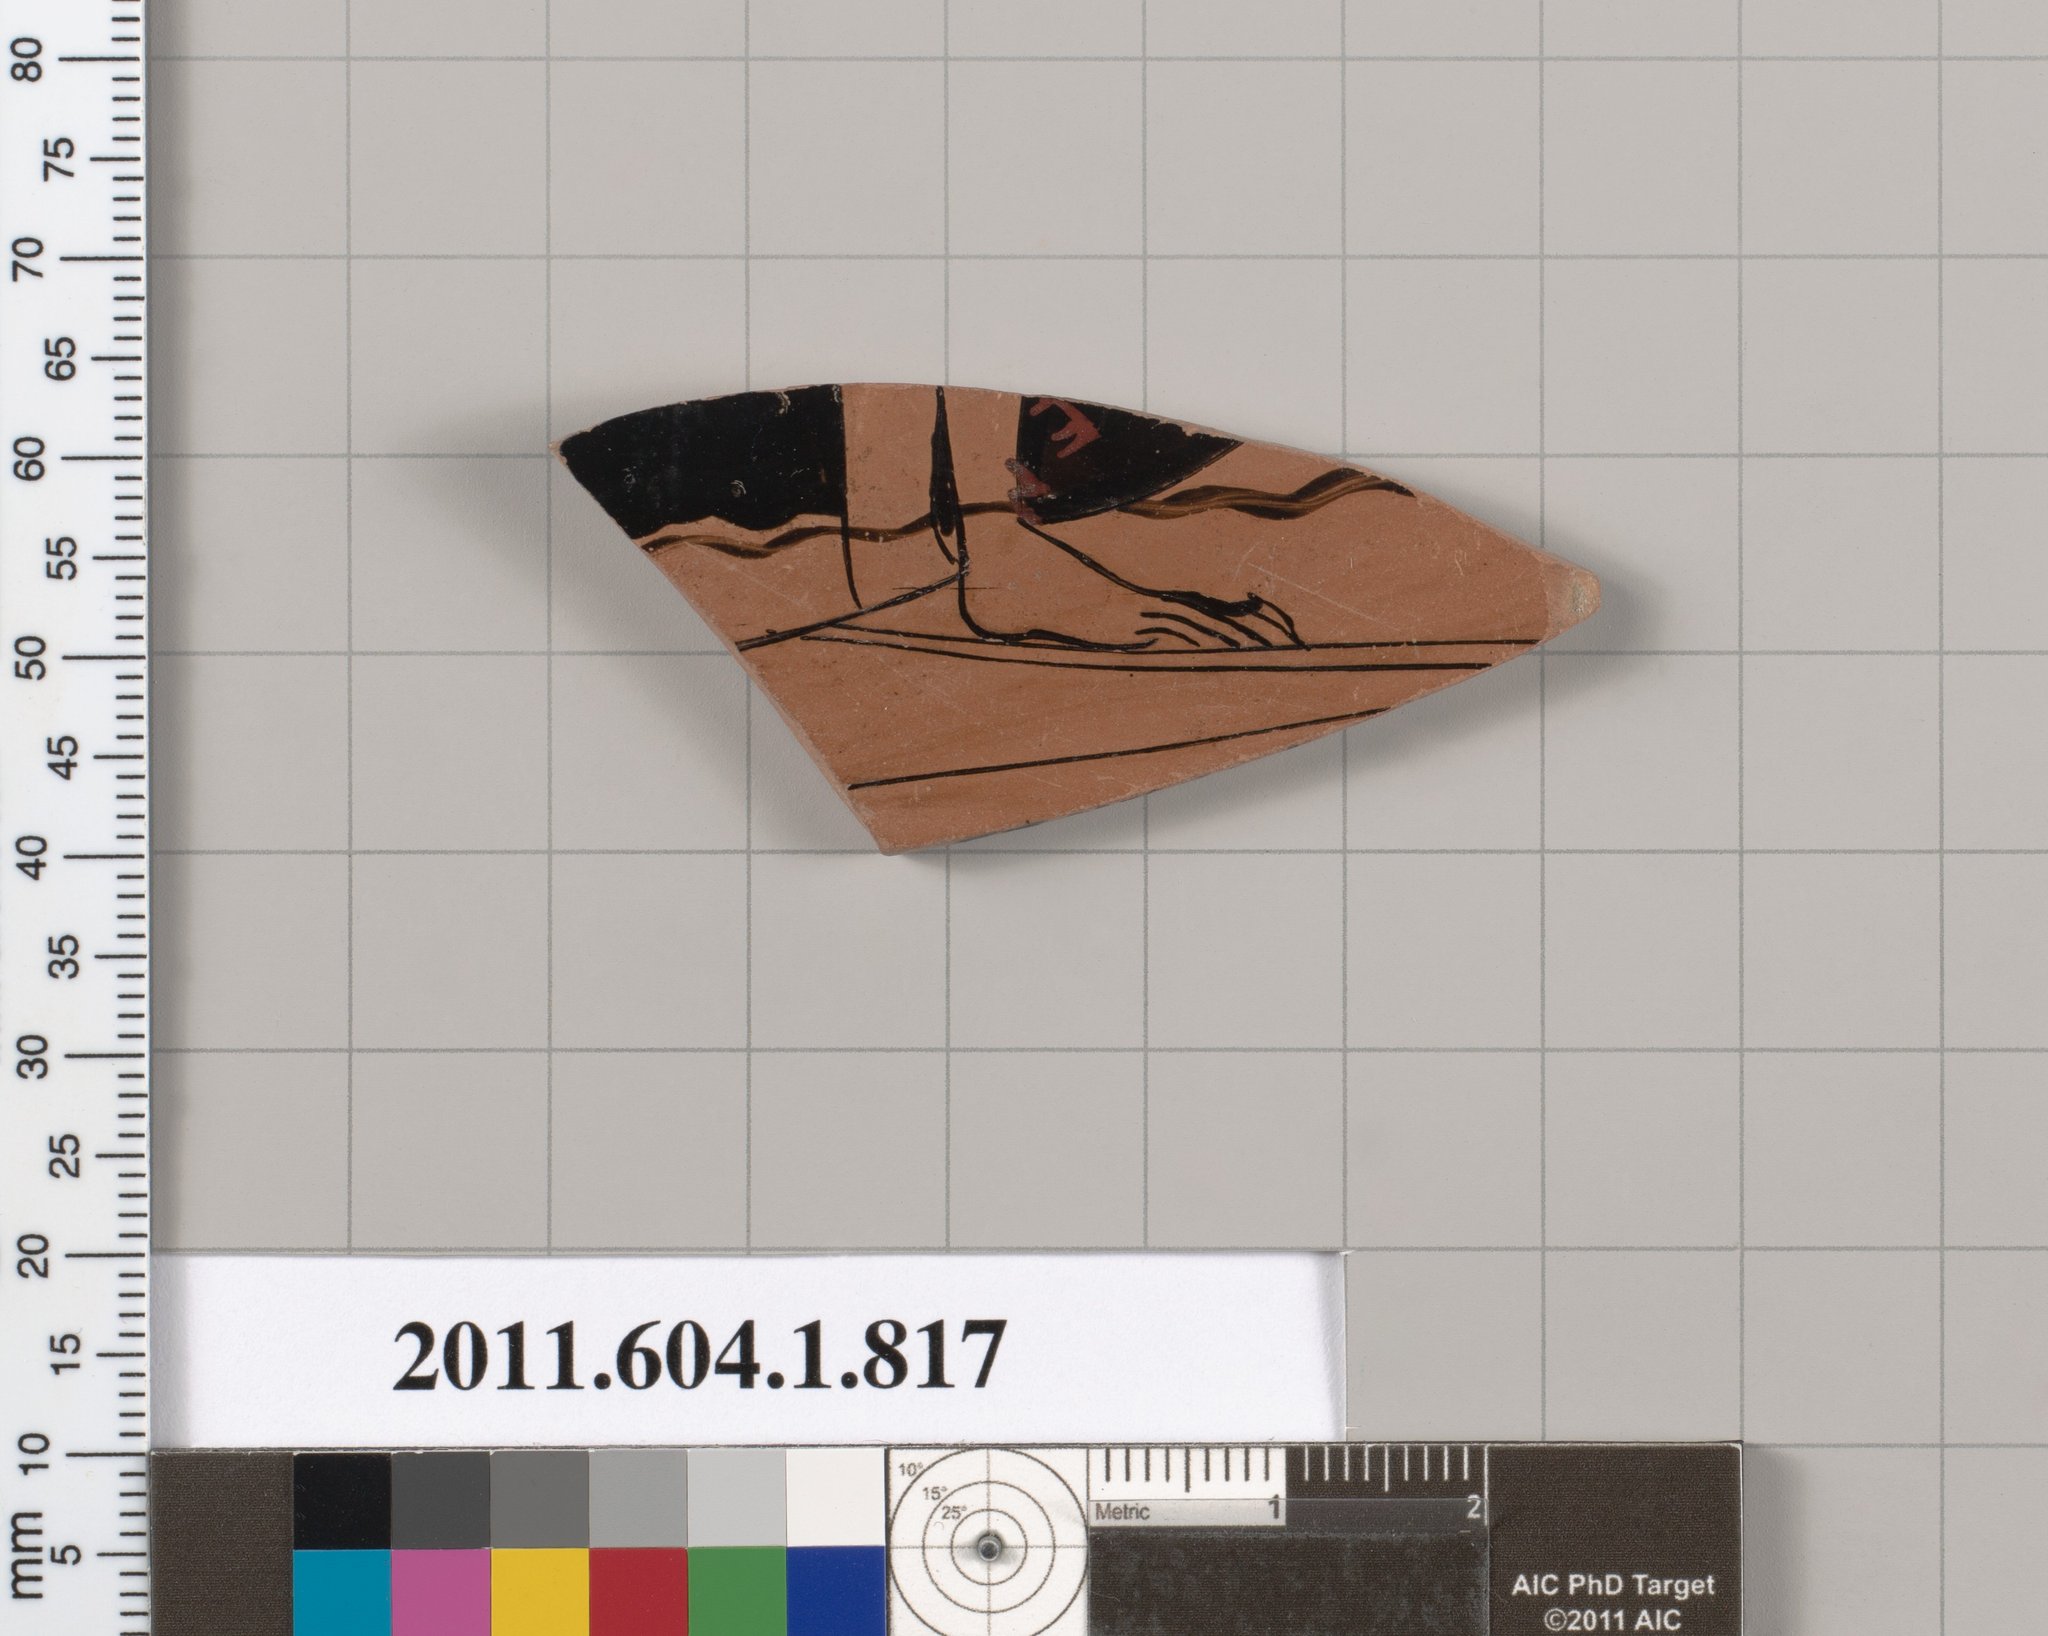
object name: kylix fragment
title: Terracotta fragment of a kylix (drinking cup)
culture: greek, attic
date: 490-480 BCE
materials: terracotta